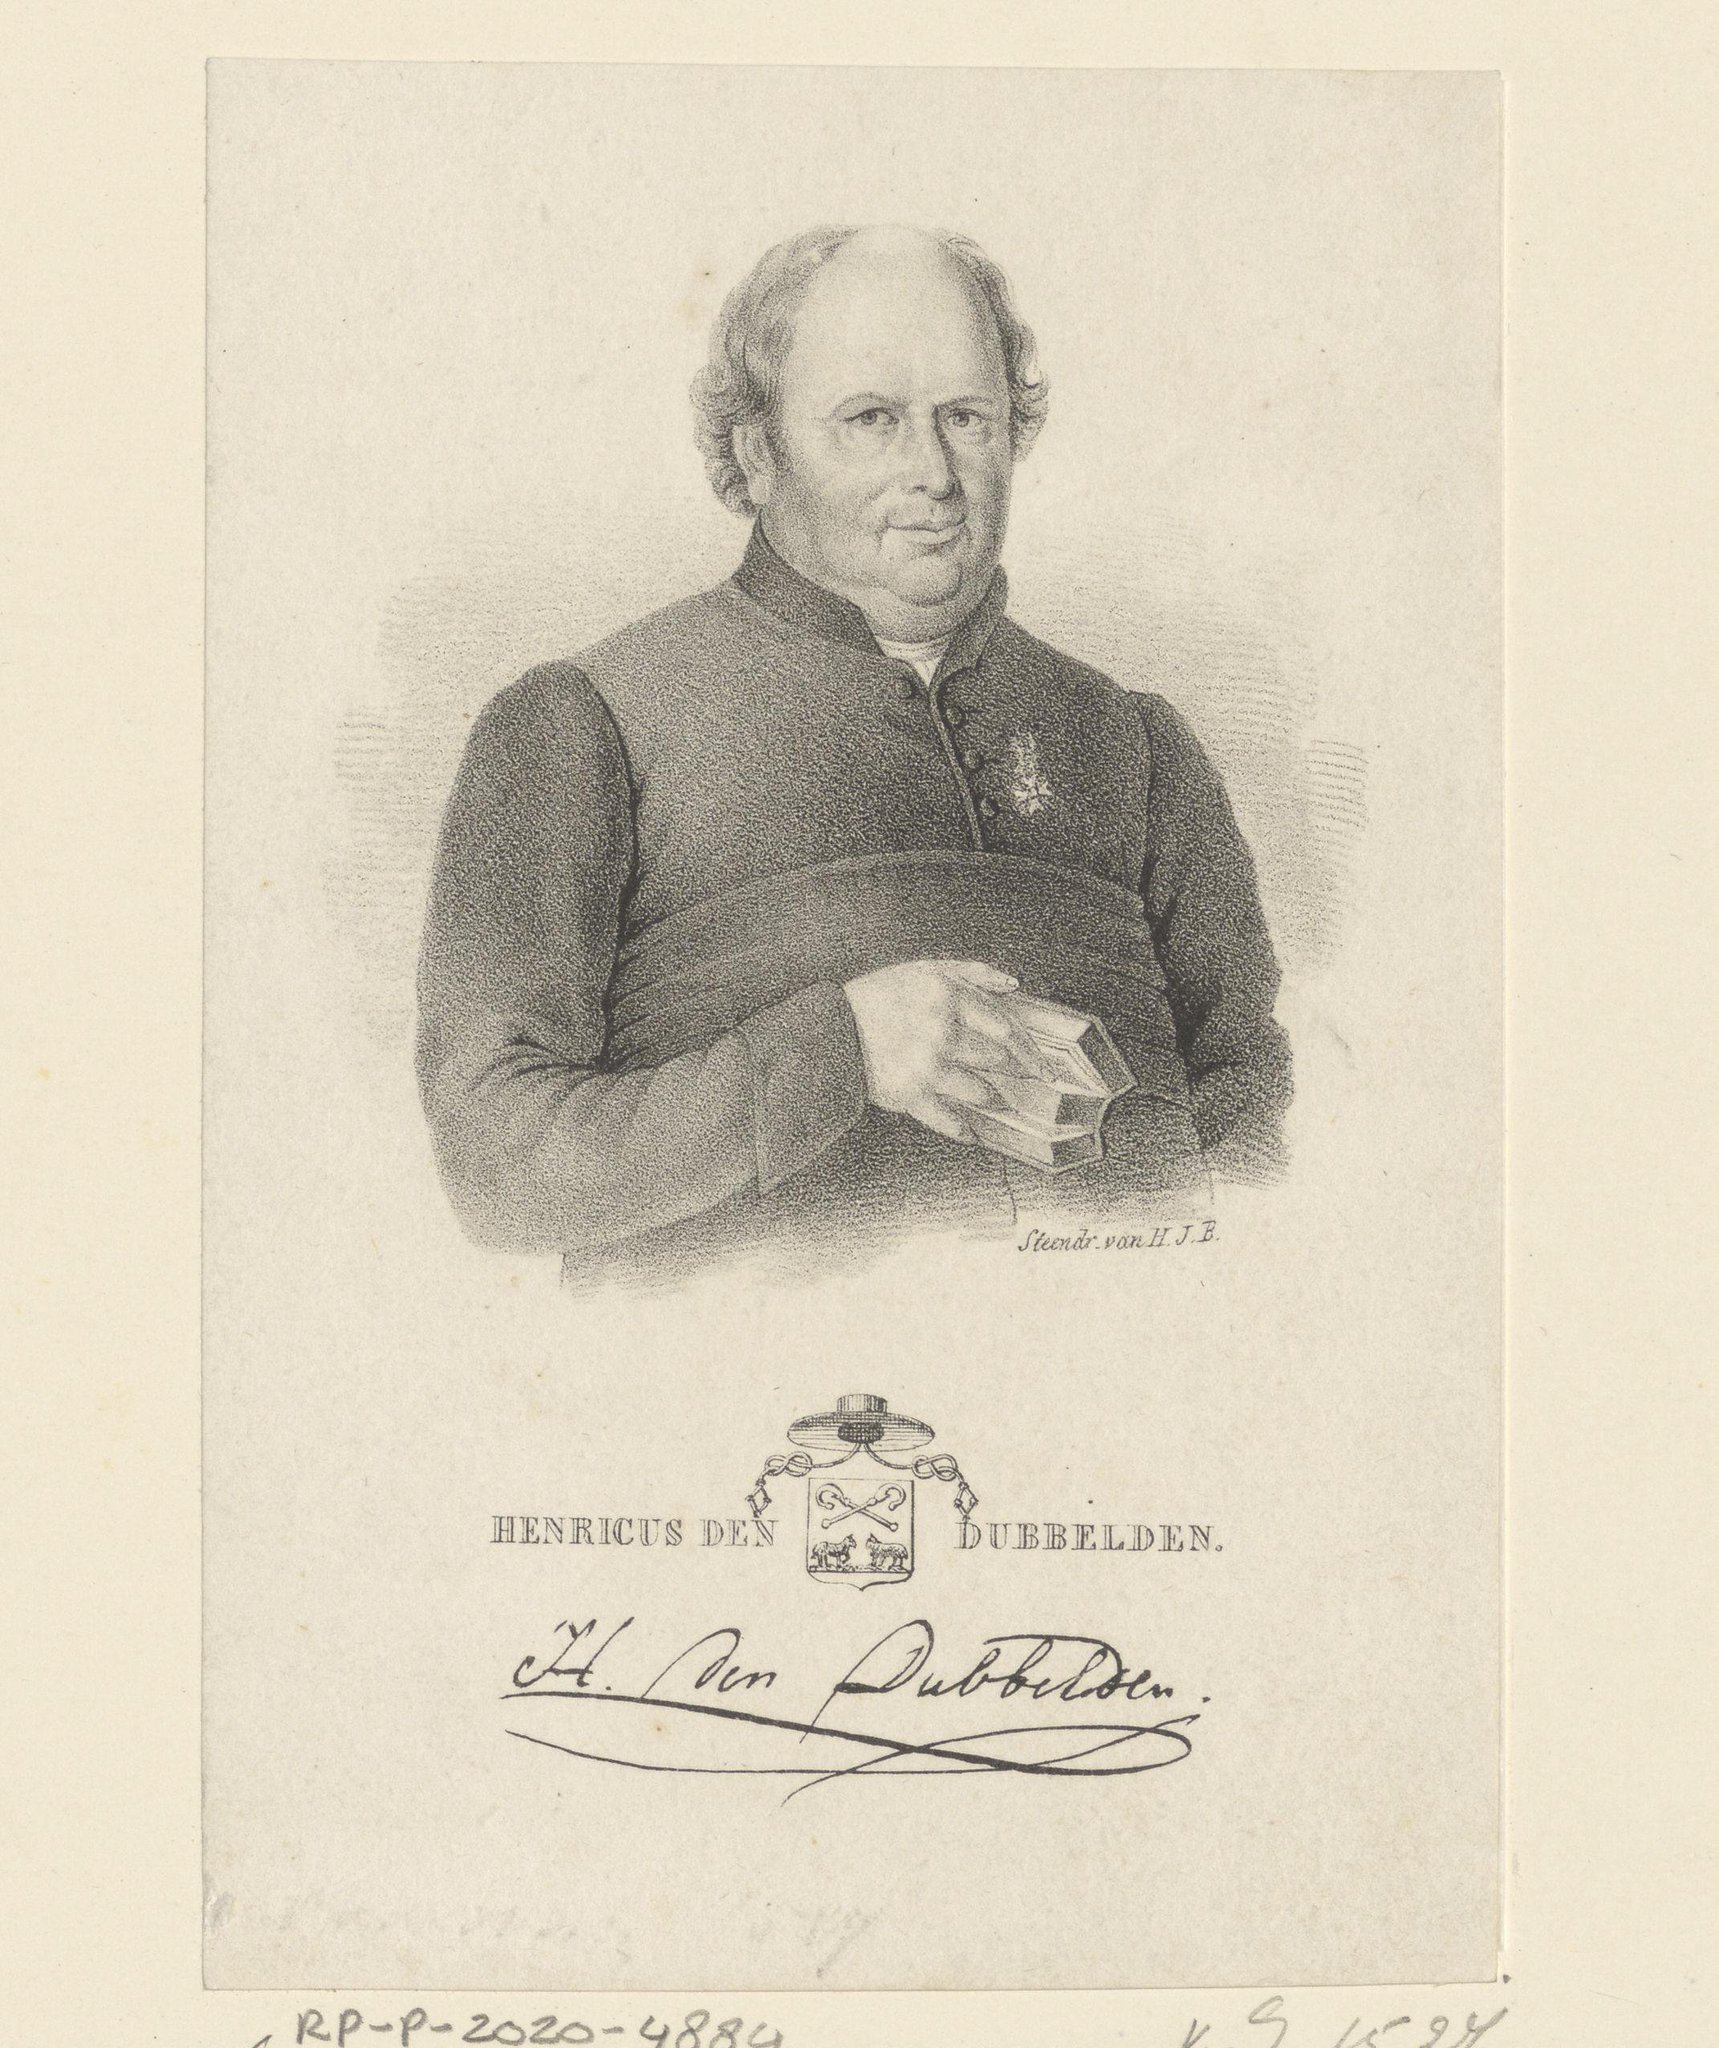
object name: print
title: Portret van Henricus den Dubbelden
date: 1837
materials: paper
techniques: lithograph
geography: dordrecht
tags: archbishop, bishop, etc. (roman catholic), historical persons, book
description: Prent waarschijnlijk uit: Roomsch-Katholijk jaarboek voor het Koningrijk der Nederlanden. Breda: W.A. Oukoop, 1837, dl. 3.